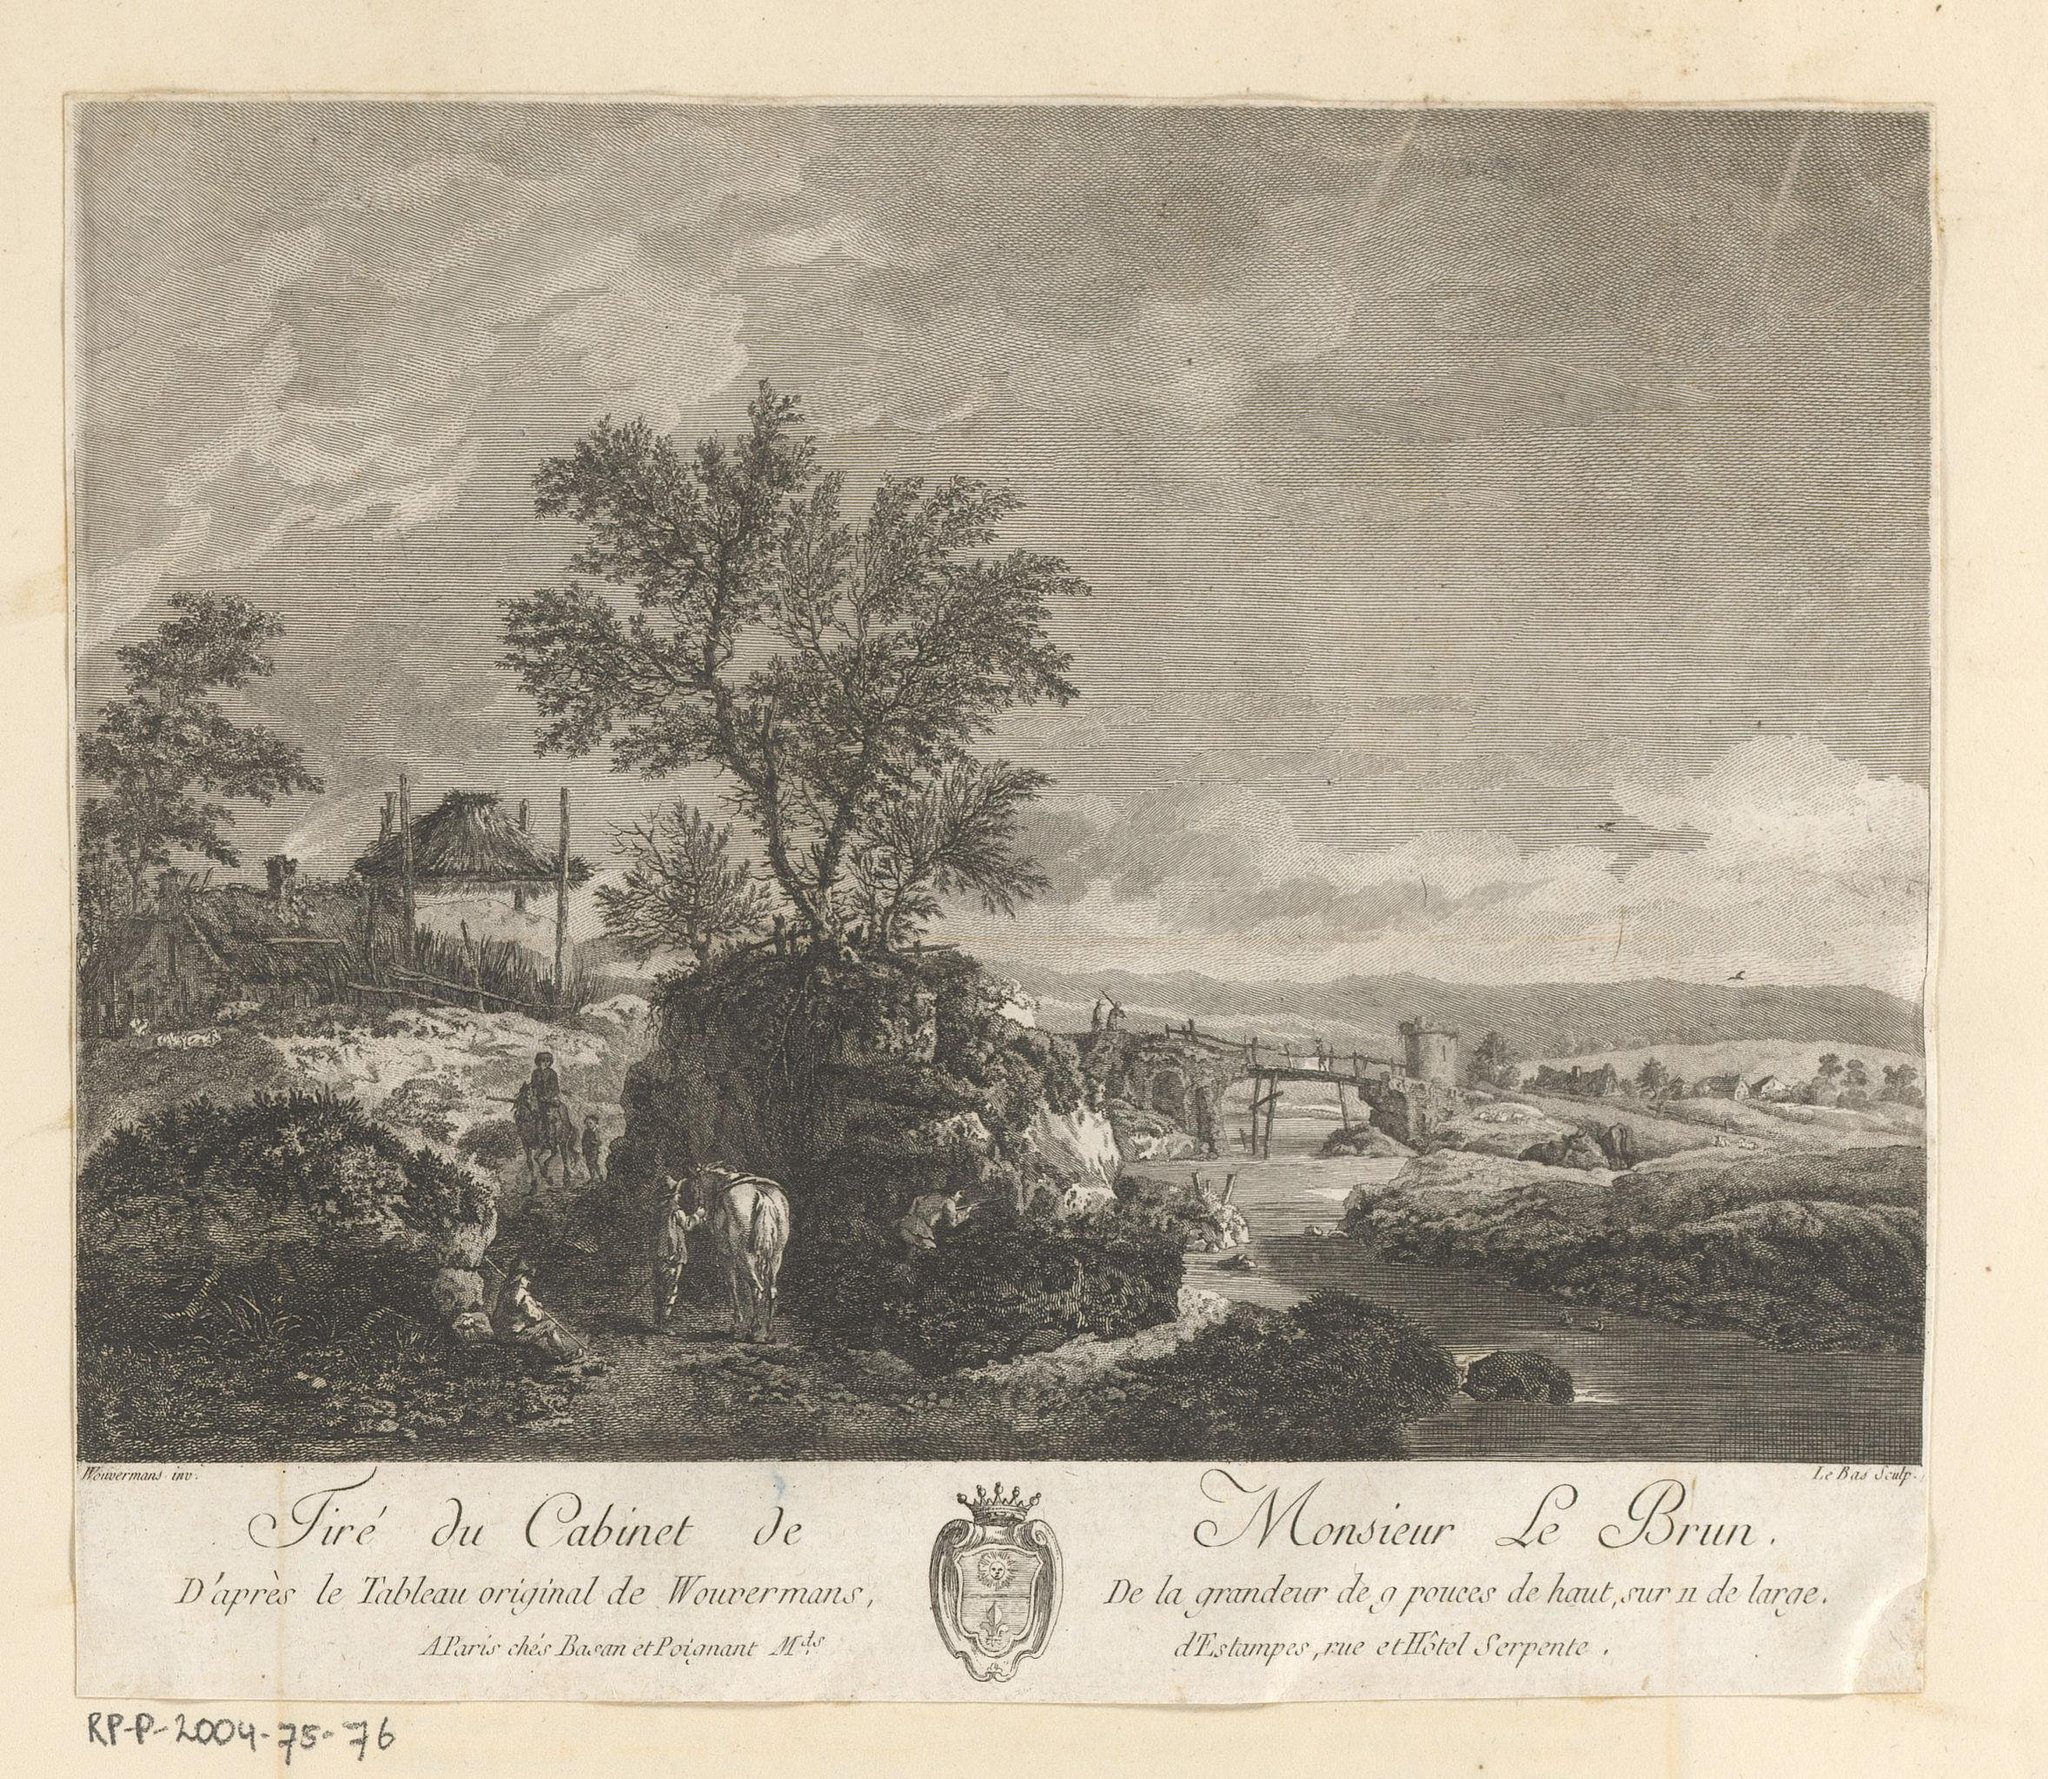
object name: album leaf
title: Landschap met jagers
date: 1796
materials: paper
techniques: engraving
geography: paris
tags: low hill country (+ landscape with figures, staffage)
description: Prent uit: Lebrun, Jean-Baptiste-Pierre. Galerie des peintres flamands, hollandais et allemands : ouvrage enrichi de deux cent une planches gravées d'après les meilleurs tableaux de ces maîtres, par les plus habiles artistes de France. 3 dln. Parijs: Jean-Baptiste-Pierre Lebrun, Parijs: Etienne Léon Poignant, Amsterdam: Pieter Fouquet (II), [1792-1796], dl. 2, p. 52. De samensteller heeft deze prent in het album geplakt als illustratie bij: Pilkington, Matthew en Johann Heinrich Füssli. A dictionary of painters, from the revival of the art to the present period. 4 dln. Londen: John Crowder, 1805, dl. 4, p. 656.